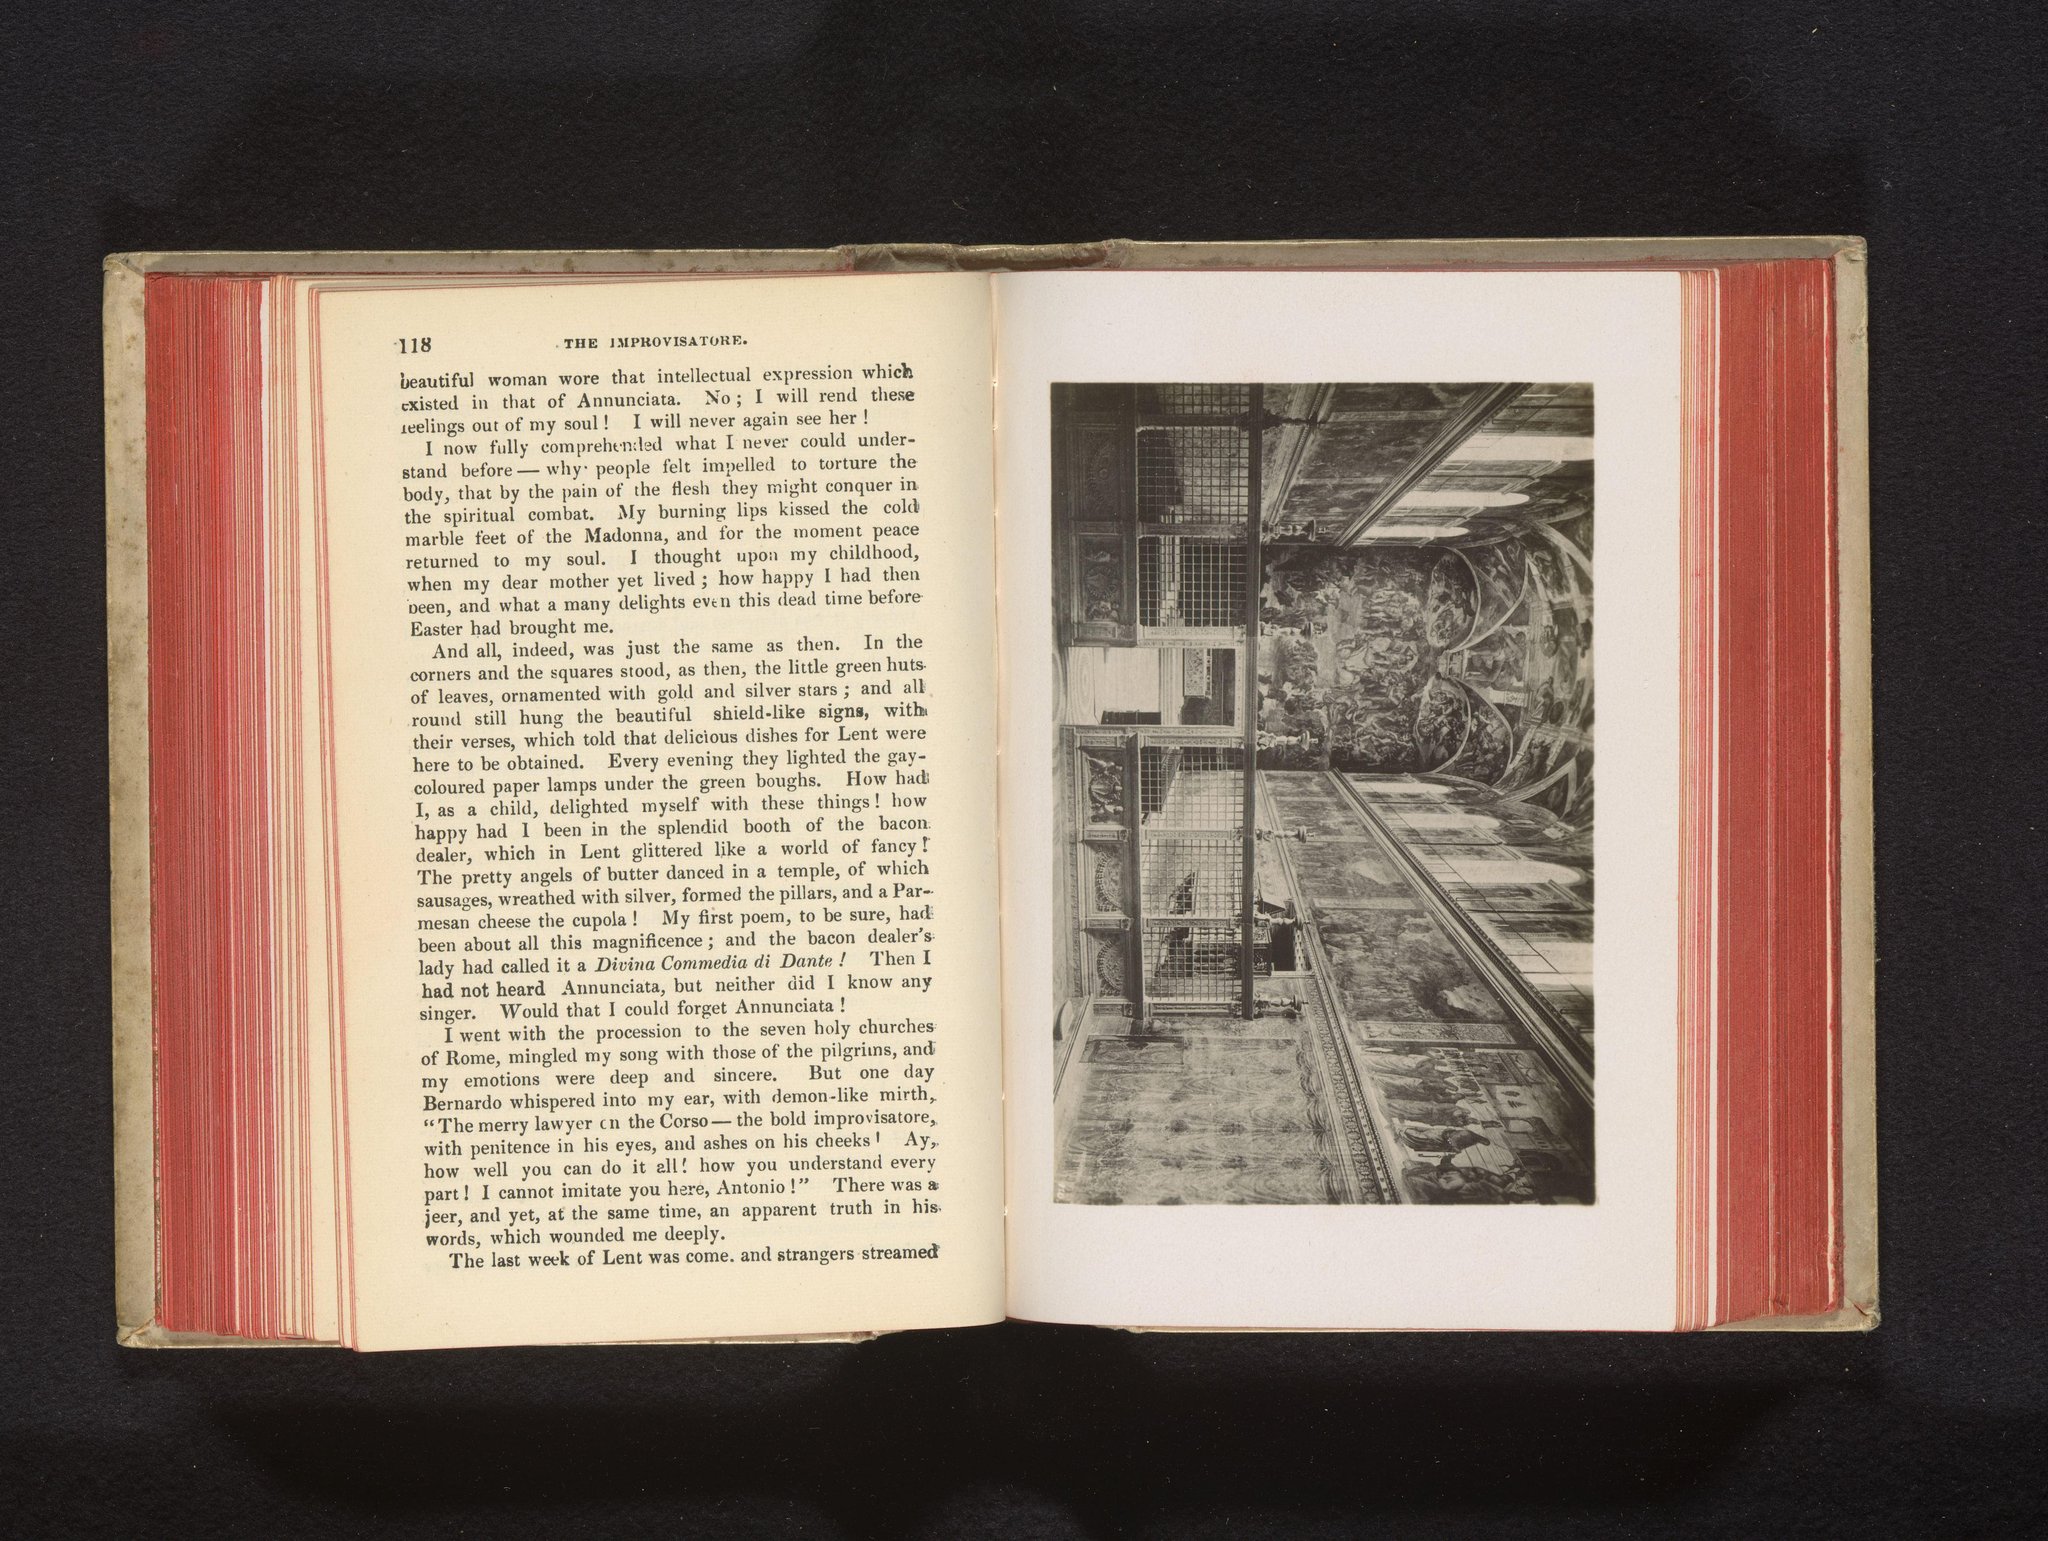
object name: page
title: Interieur van de Sixtijnse Kapel te Vaticaanstad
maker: Anonymous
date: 1870-1880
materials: photographic support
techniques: gelatin silver print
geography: vatican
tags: interior ~ representation of a building, parts of church interior: chapel